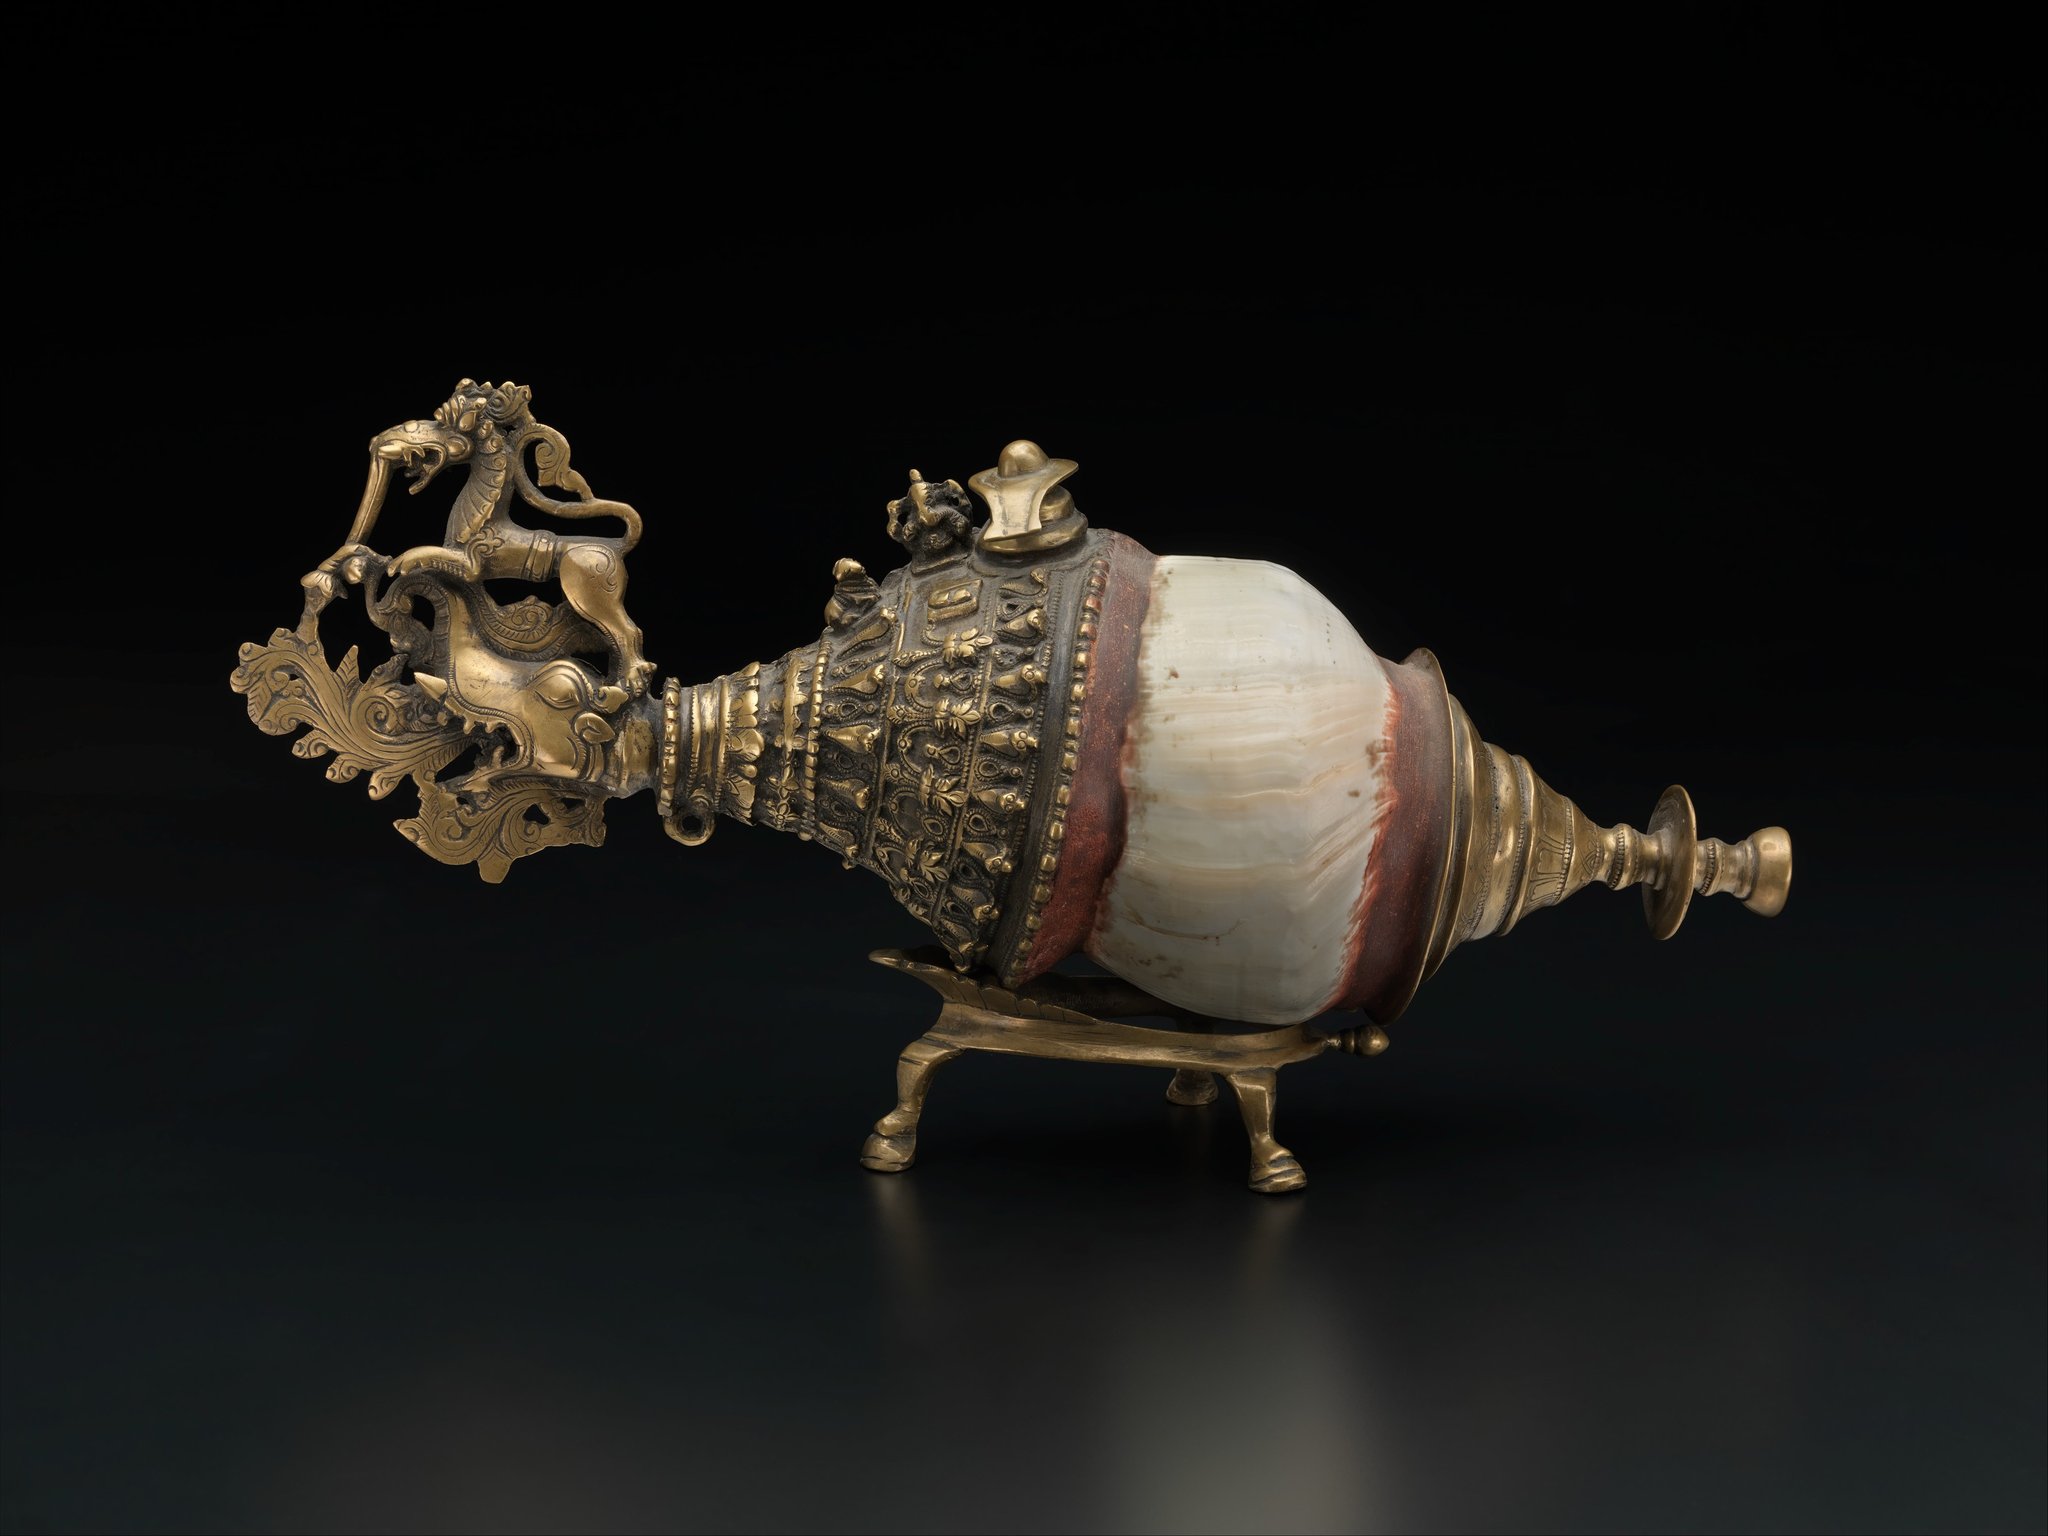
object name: sankh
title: Śankh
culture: indian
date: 1801-1900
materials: brass, shell, wax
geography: india